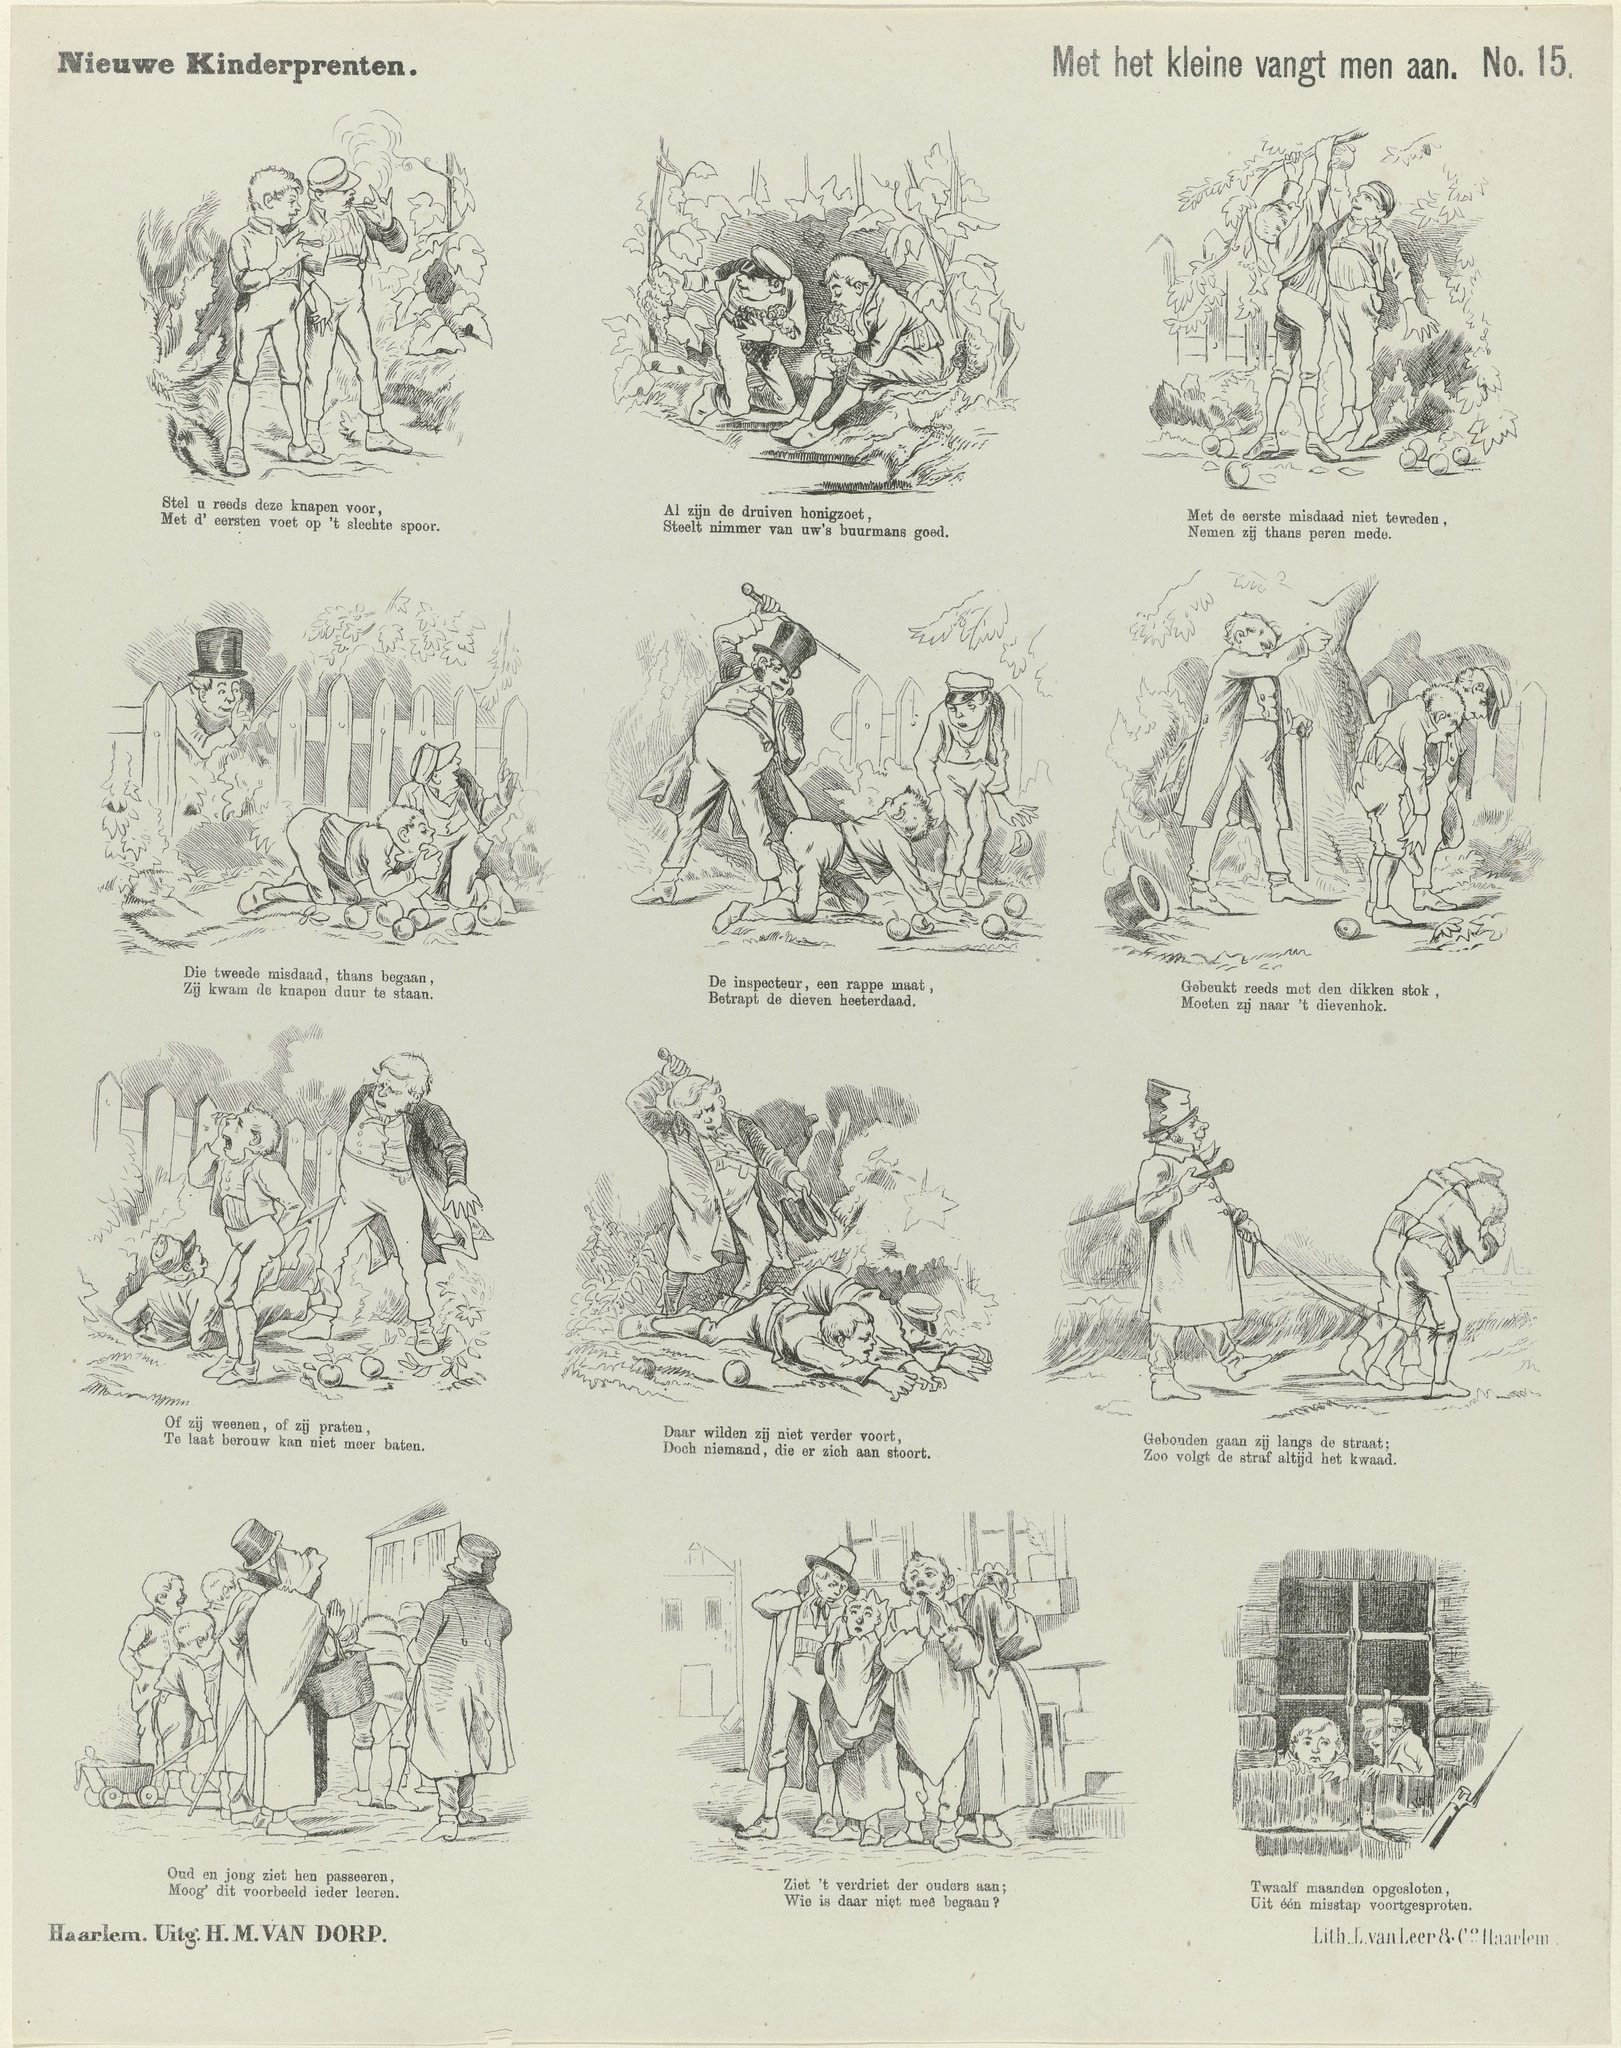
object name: print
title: Met het kleine vangt men aan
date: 1872-1883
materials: paper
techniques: letterpress printing, lithograph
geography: haarlem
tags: correction of naughty children, theft, imprisonment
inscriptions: collector's mark: Lugt 2760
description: Blad met 12 voorstellingen over dieven die gestraft worden. Onder elke afbeelding een tweeregelig vers. Genummerd rechtsboven: No. 15.